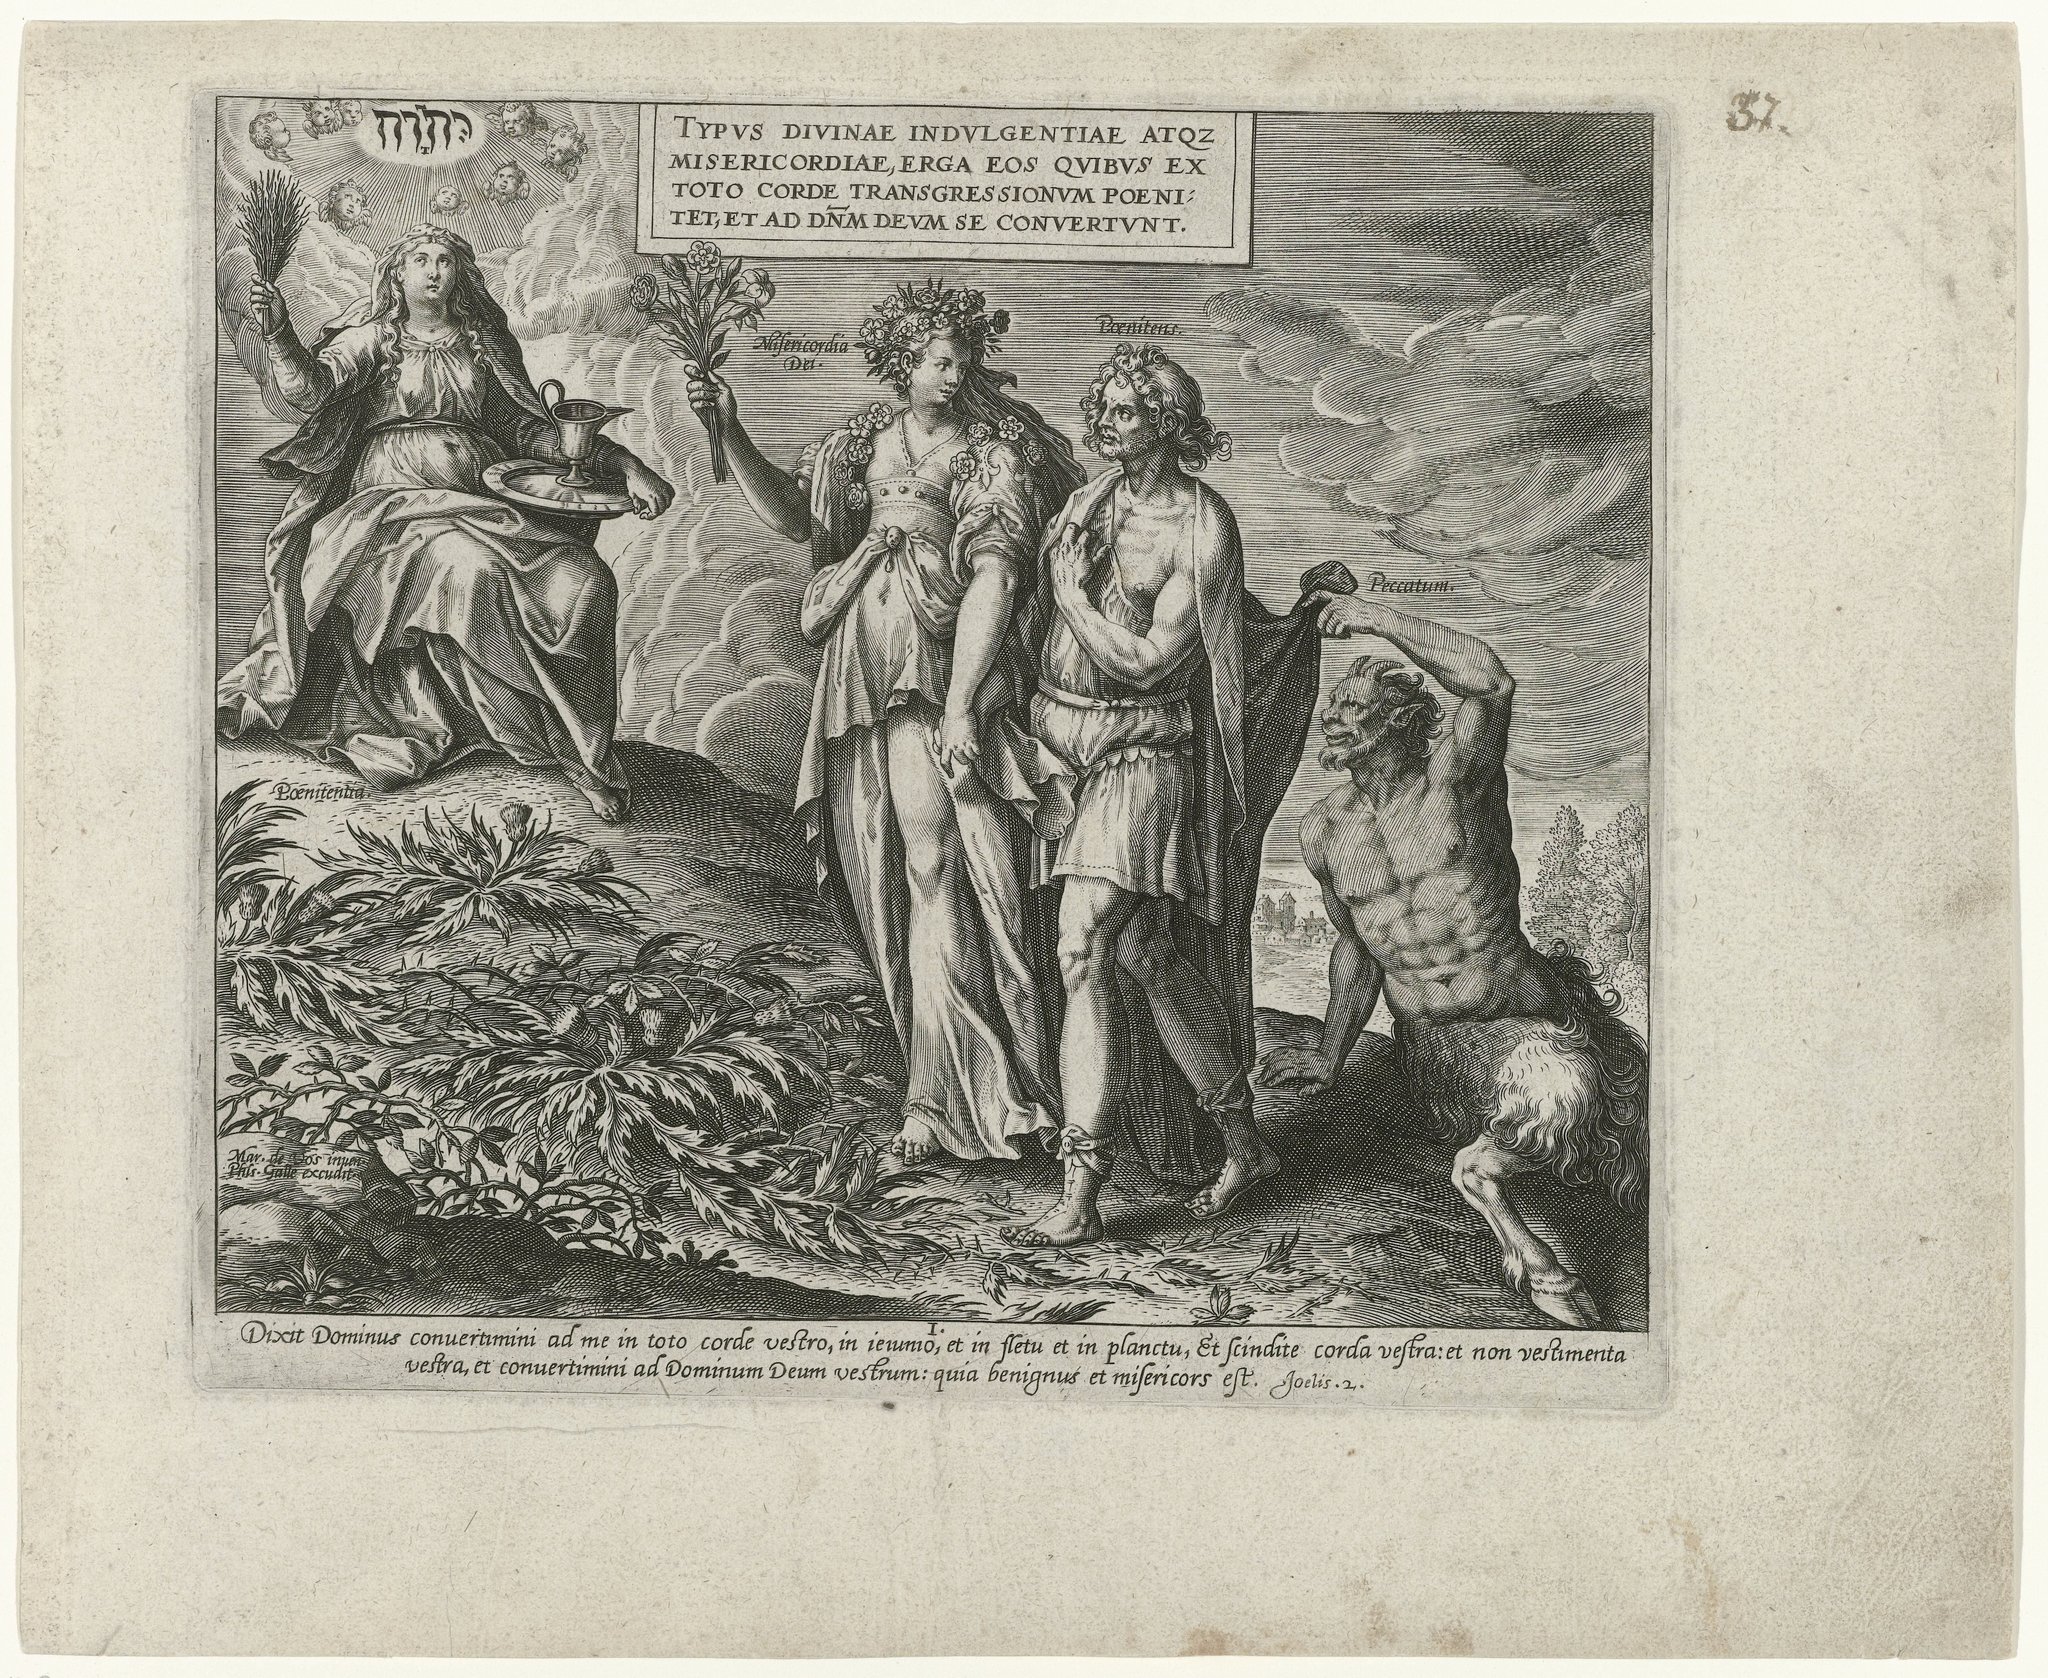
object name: print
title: Boetedoening en berouw in het Oude Testament en het Nieuwe Testament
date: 1547-1612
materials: paper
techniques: engraving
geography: antwerp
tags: penitence, repentance; 'penitenza', 'pentimento', 'pentimento de'peccati', 'purgatione de peccati' (ripa), vice, evil, sin; 'peccato' (ripa) (+ devil(s)), mercy, compassion; 'compassione', 'misericordia' (ripa)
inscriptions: number: ‘37’, collector's mark: Lugt 2228, collector's mark: Lugt 2760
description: Centraal een boeteling die door Goddelijke Barmhartigheid (Misericordia Dei) begeleid wordt richting de personicifica Berouw (Poenitentia), die op een troon zit onder het Tetragram. Zonde (Peccatum), een duivel met bokkepoten, tracht Goddelijke Barmhartigheid tegen te houden.Titelprent van een serie over boetedoening en berouw in het Oude en Nieuwe Testament en heeft een Latijns opschrift en onderschrift